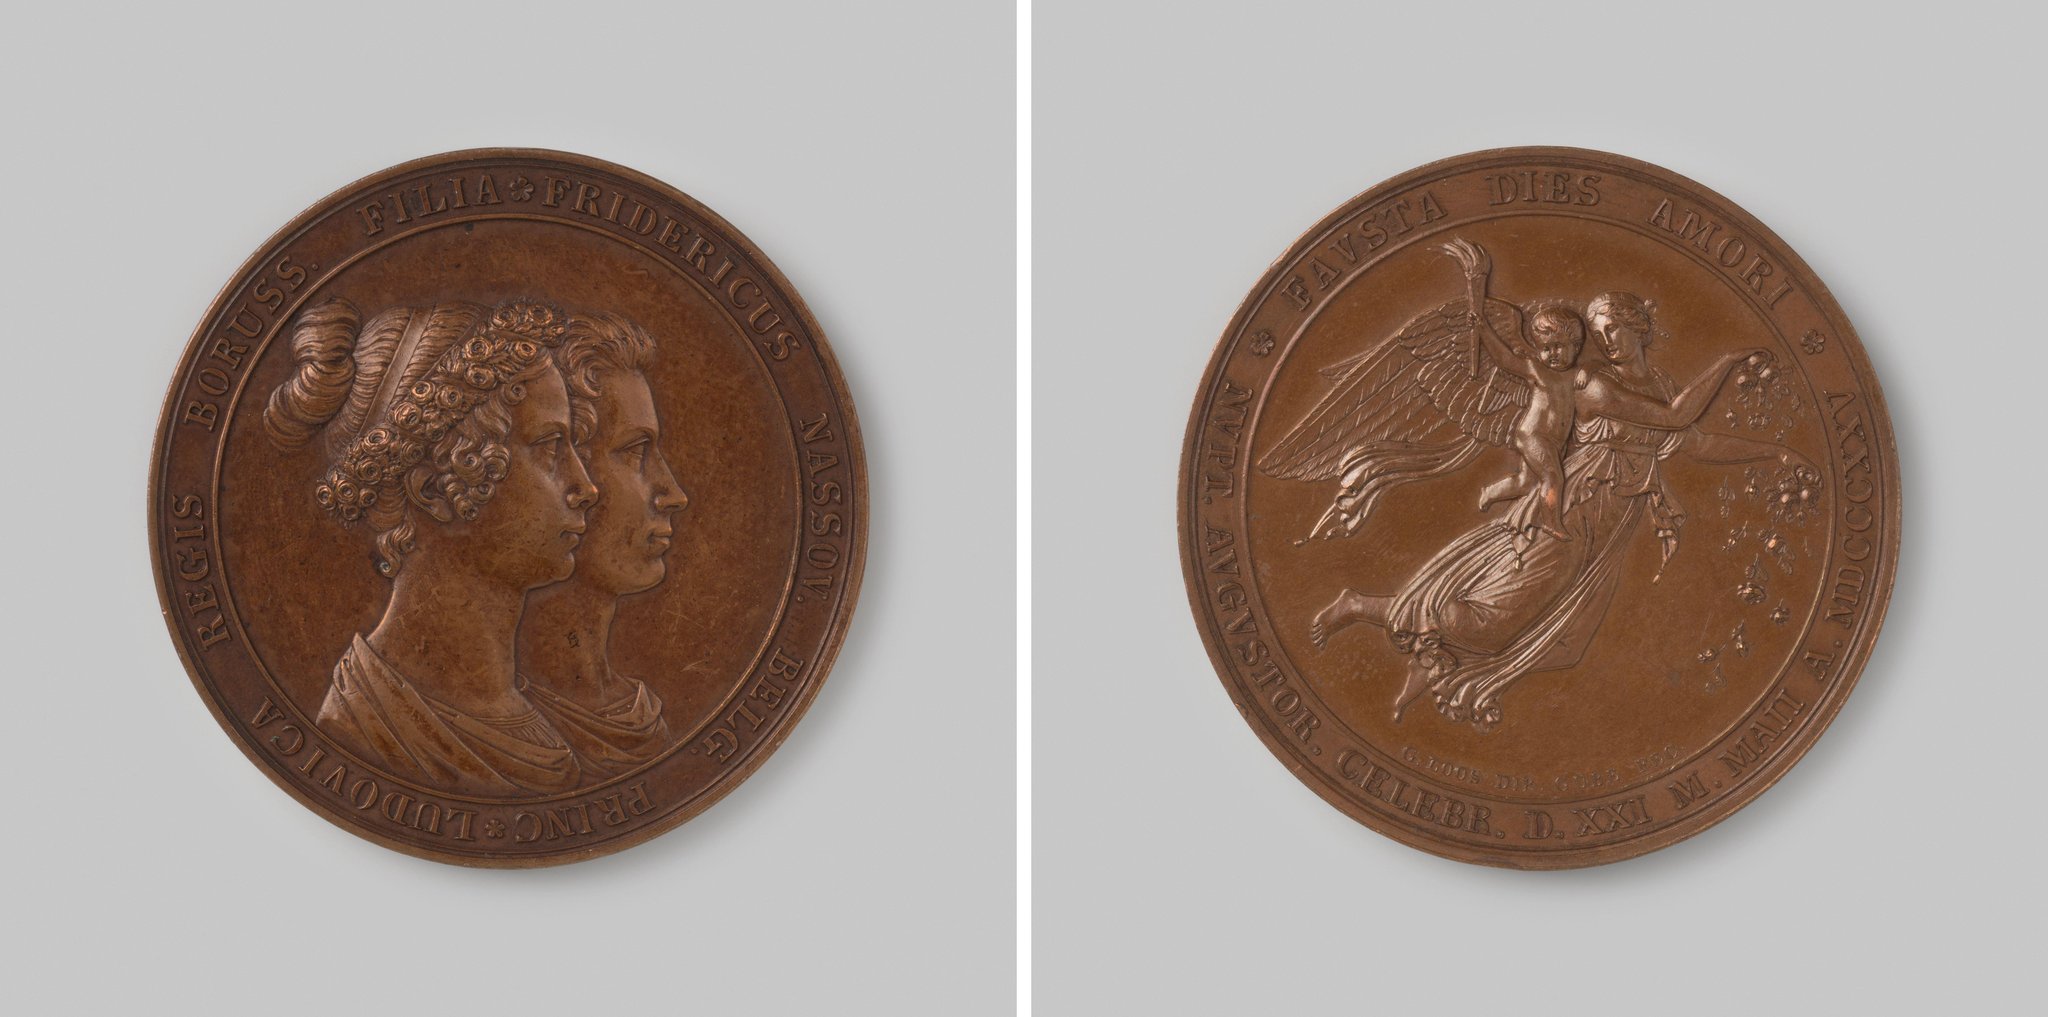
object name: history medal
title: Huwelijk van Prins Frederik van Oranje en Prinses Louise van Pruisen 1825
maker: heinrich gube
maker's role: medailleur, muntmaker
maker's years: 1805-1848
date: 1825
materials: bronze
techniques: striking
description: Bronzen penning, op de voorzijde de geconjugeerde portretten van Frederik en Louise naar rechts, met omschrift, op de keerzijde een vliegende Venus, Amor met toorts op de rug, met omschrift.